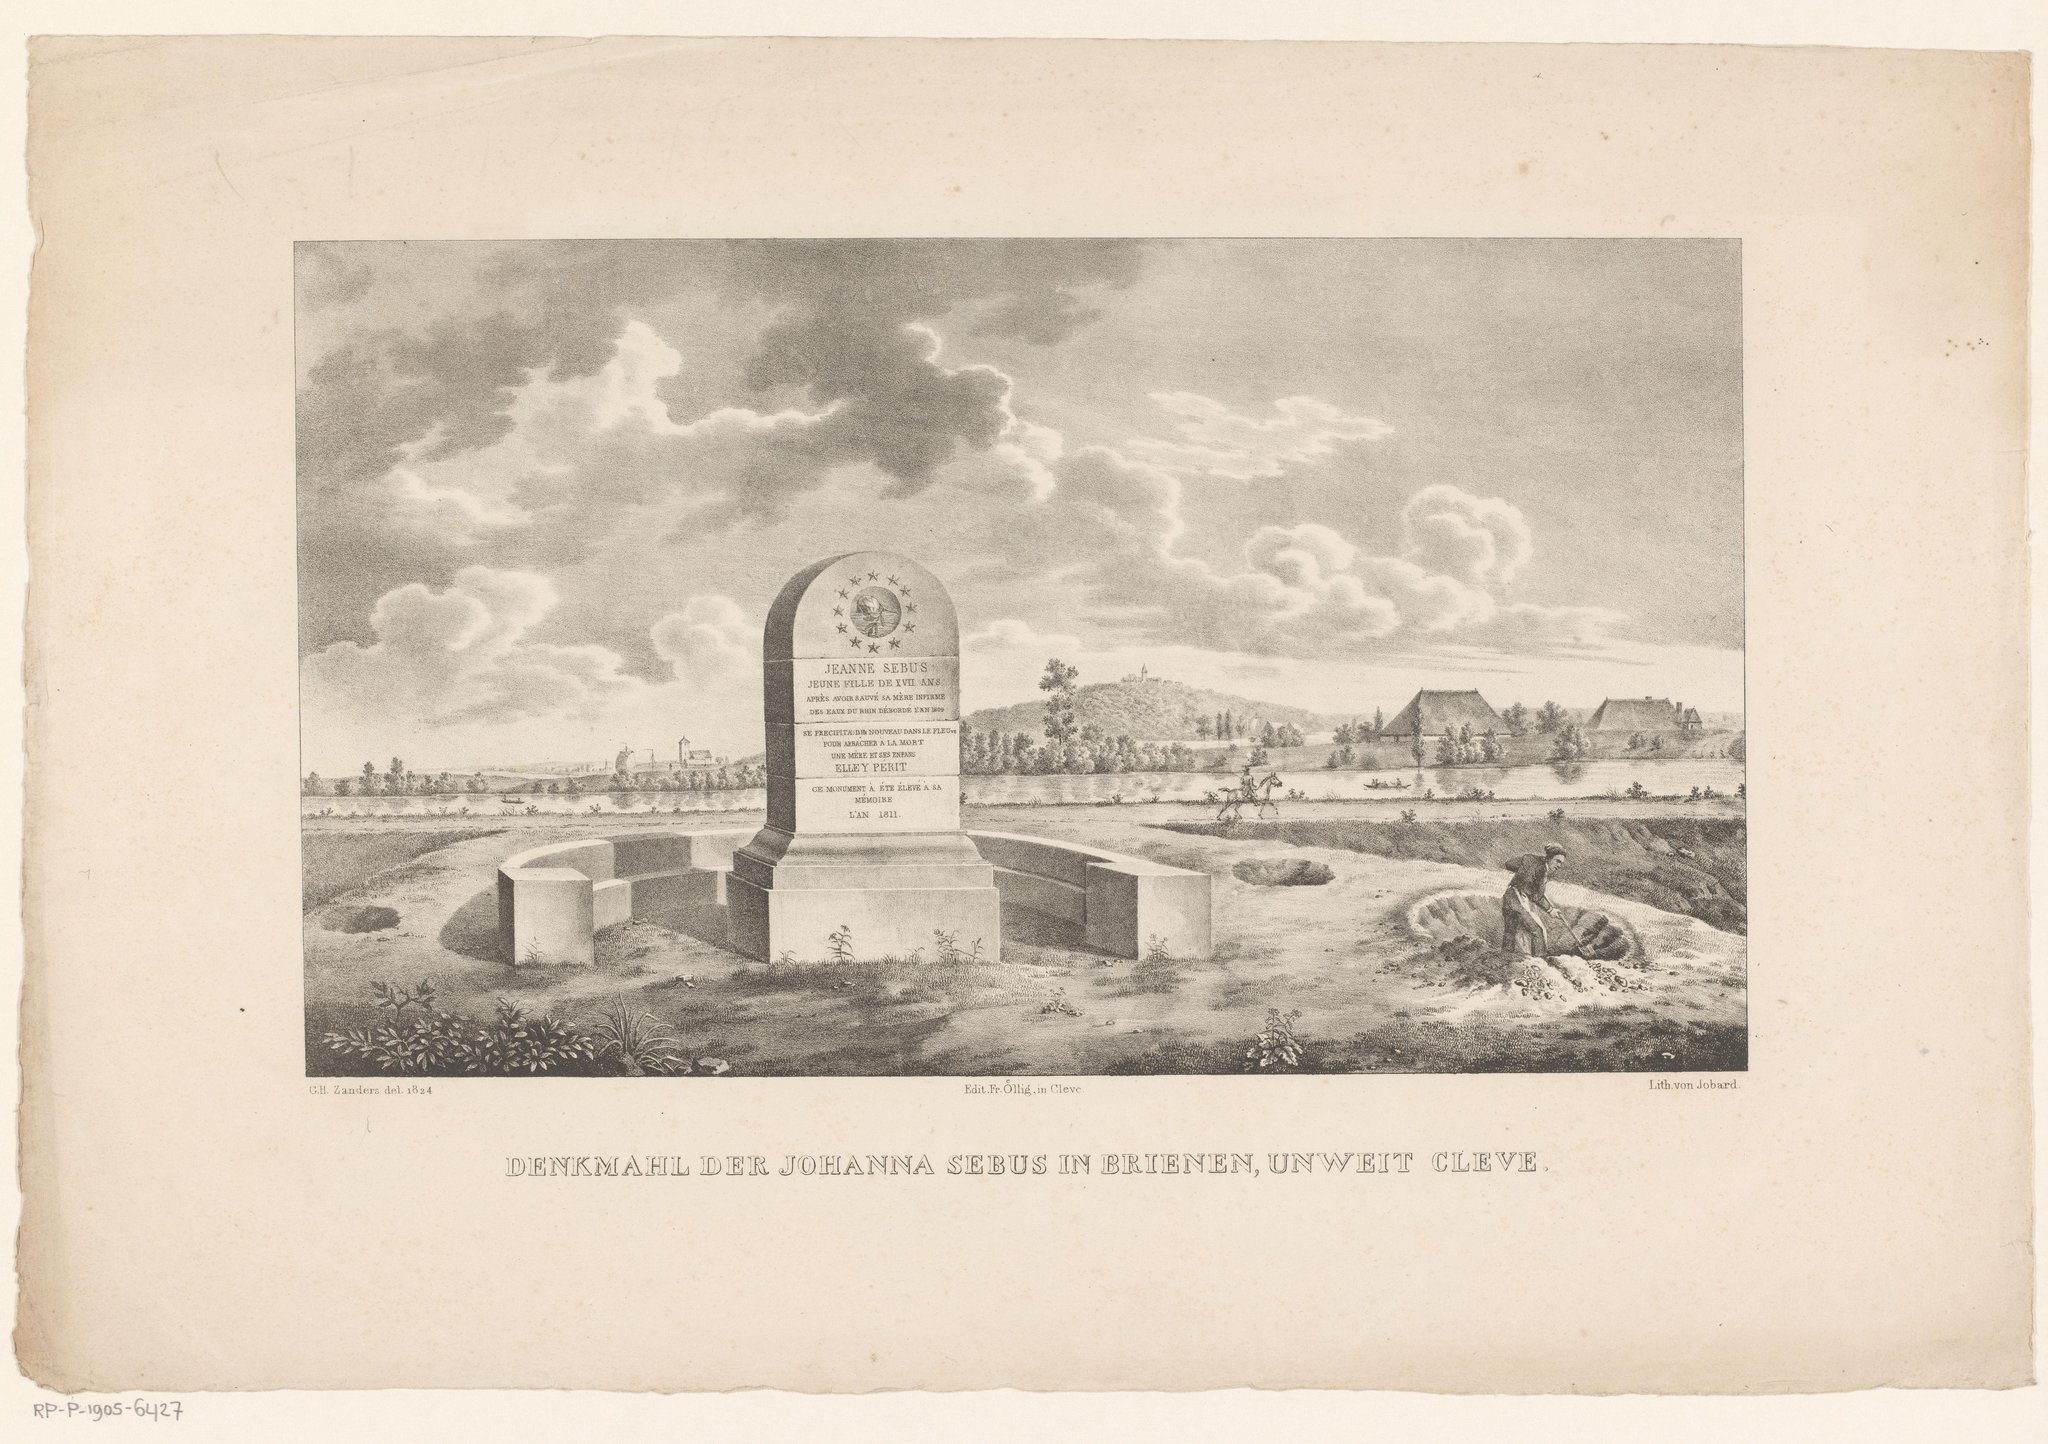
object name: print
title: Gezicht op het monument voor Johanna Sebus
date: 1826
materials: paper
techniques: lithograph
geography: cleves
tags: grave, tomb, landscape with monument, cleves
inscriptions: collector's mark: Lugt 2228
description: Prent verschenen in: Verzameling van twaalf Cleefsche gezigten. Deze publicatie bevat 12 litho's, die in afleveringen verschenen als illustratie bij de tekst. Het Rijksmuseum Amsterdam bezit er hier 7 van.